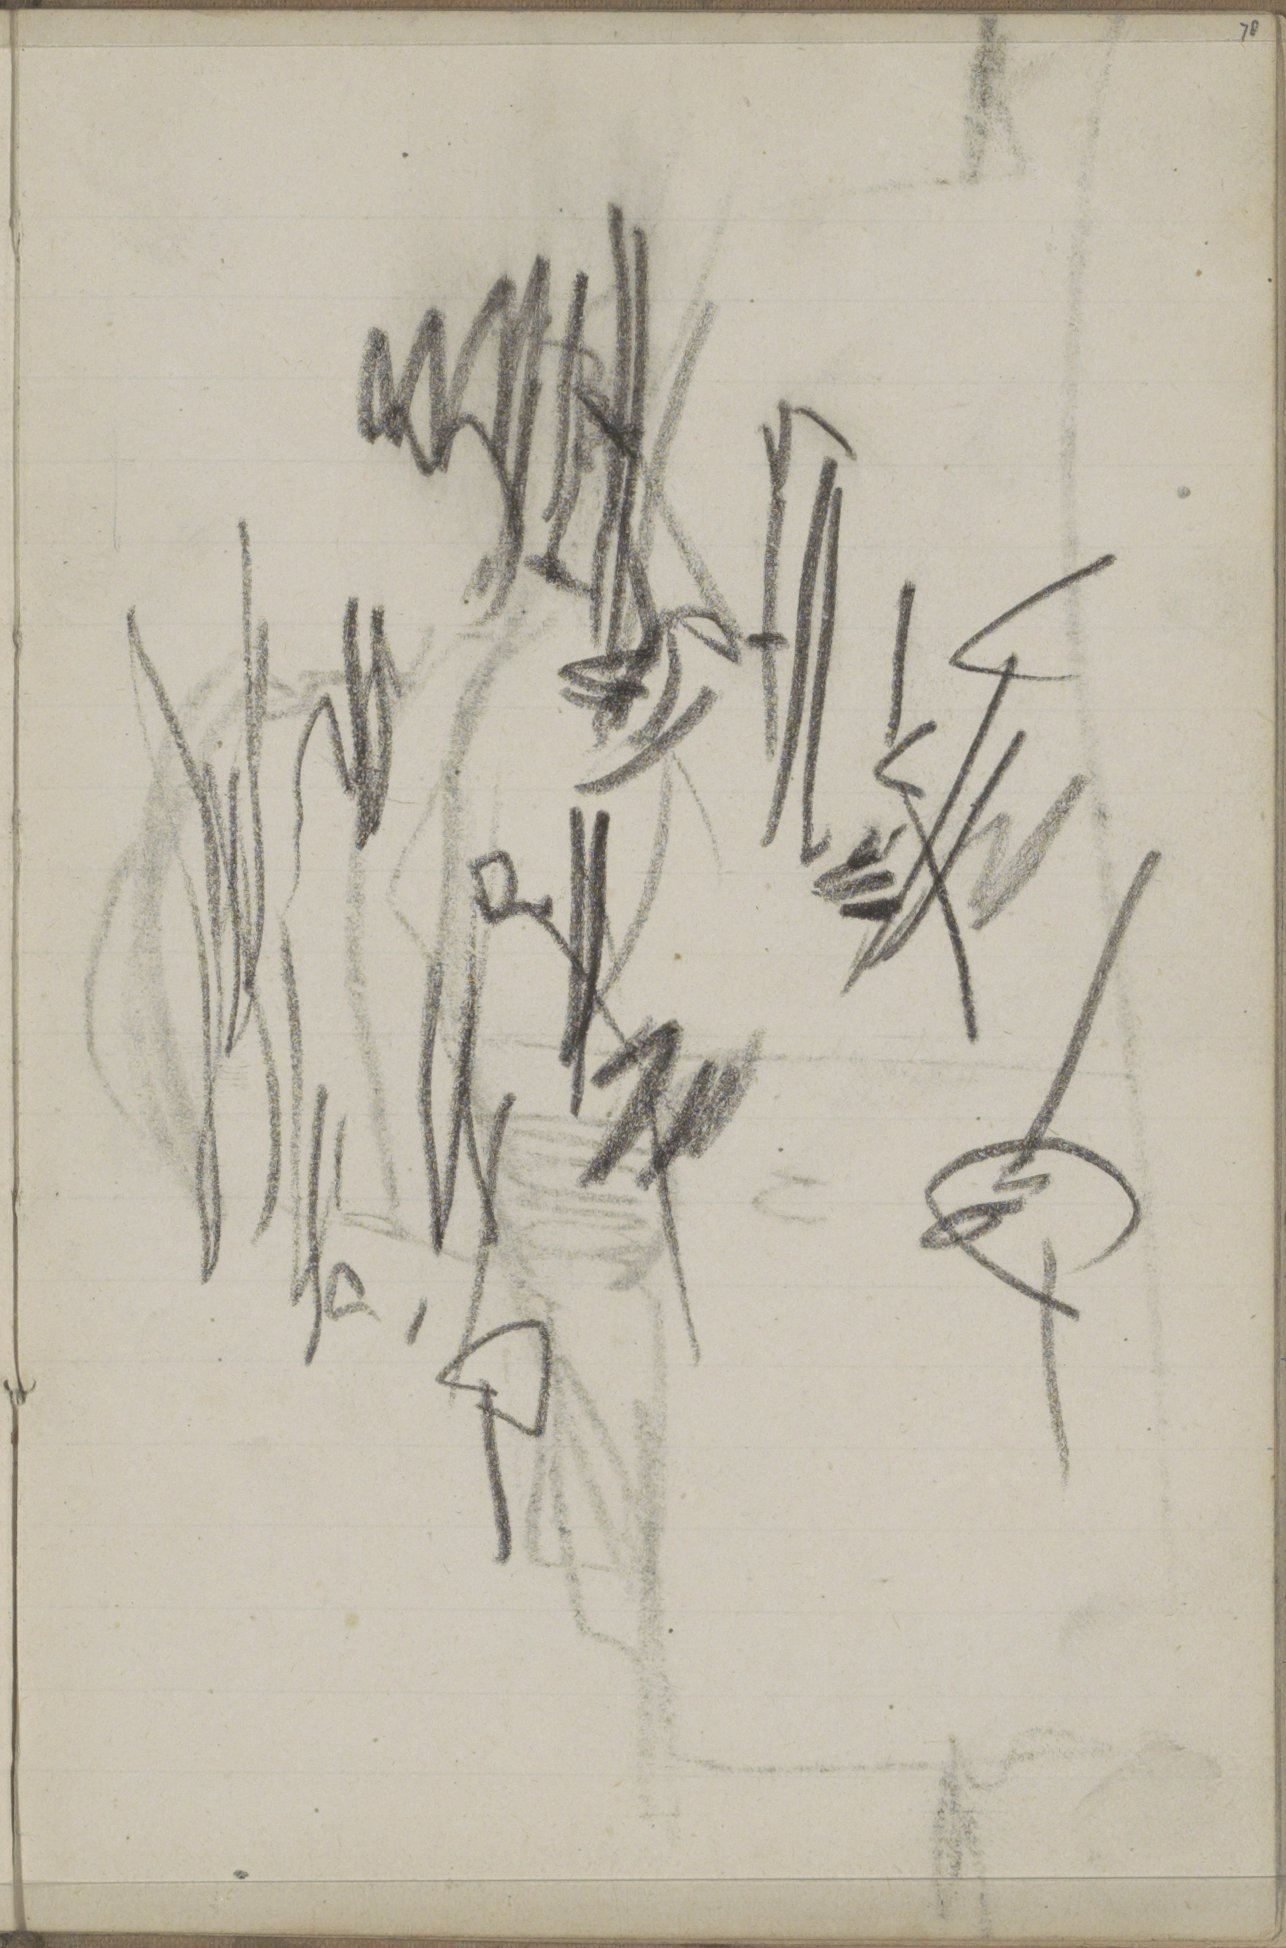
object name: sketchbook leaf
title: Studieblad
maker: marius bauer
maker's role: draughtsman, print maker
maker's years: 1867-1932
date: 1888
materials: chalk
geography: istanbul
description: Pagina 78 uit een schetsboek met 56 bladen.